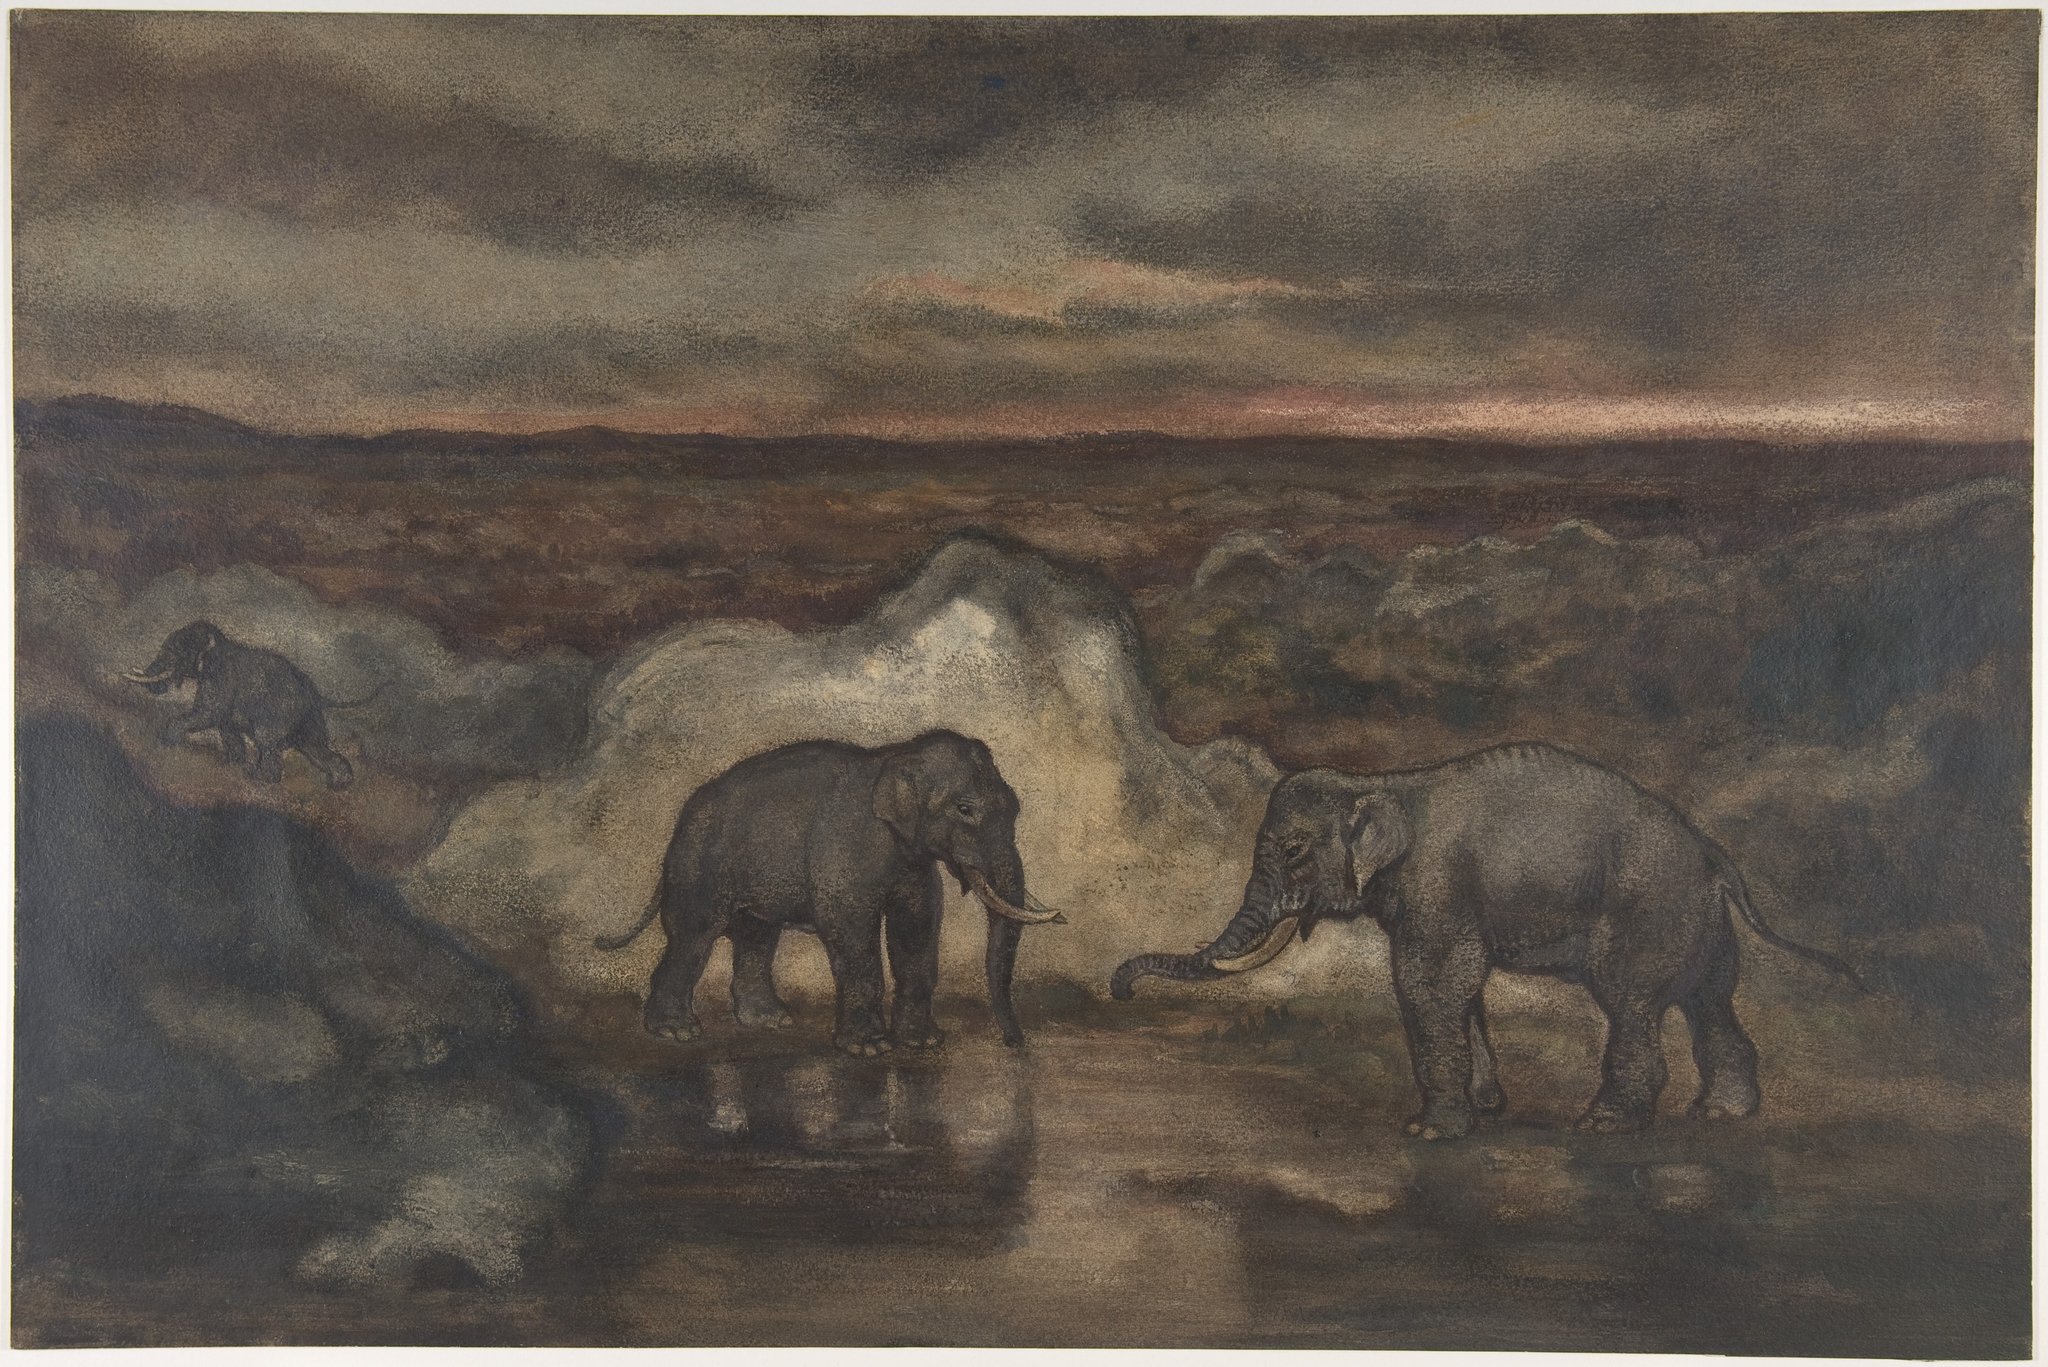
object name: drawing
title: Elephants by a Pool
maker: antoine-louis barye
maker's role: artist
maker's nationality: french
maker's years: 1795-1875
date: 1810-1875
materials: watercolor, paper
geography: france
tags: elephants